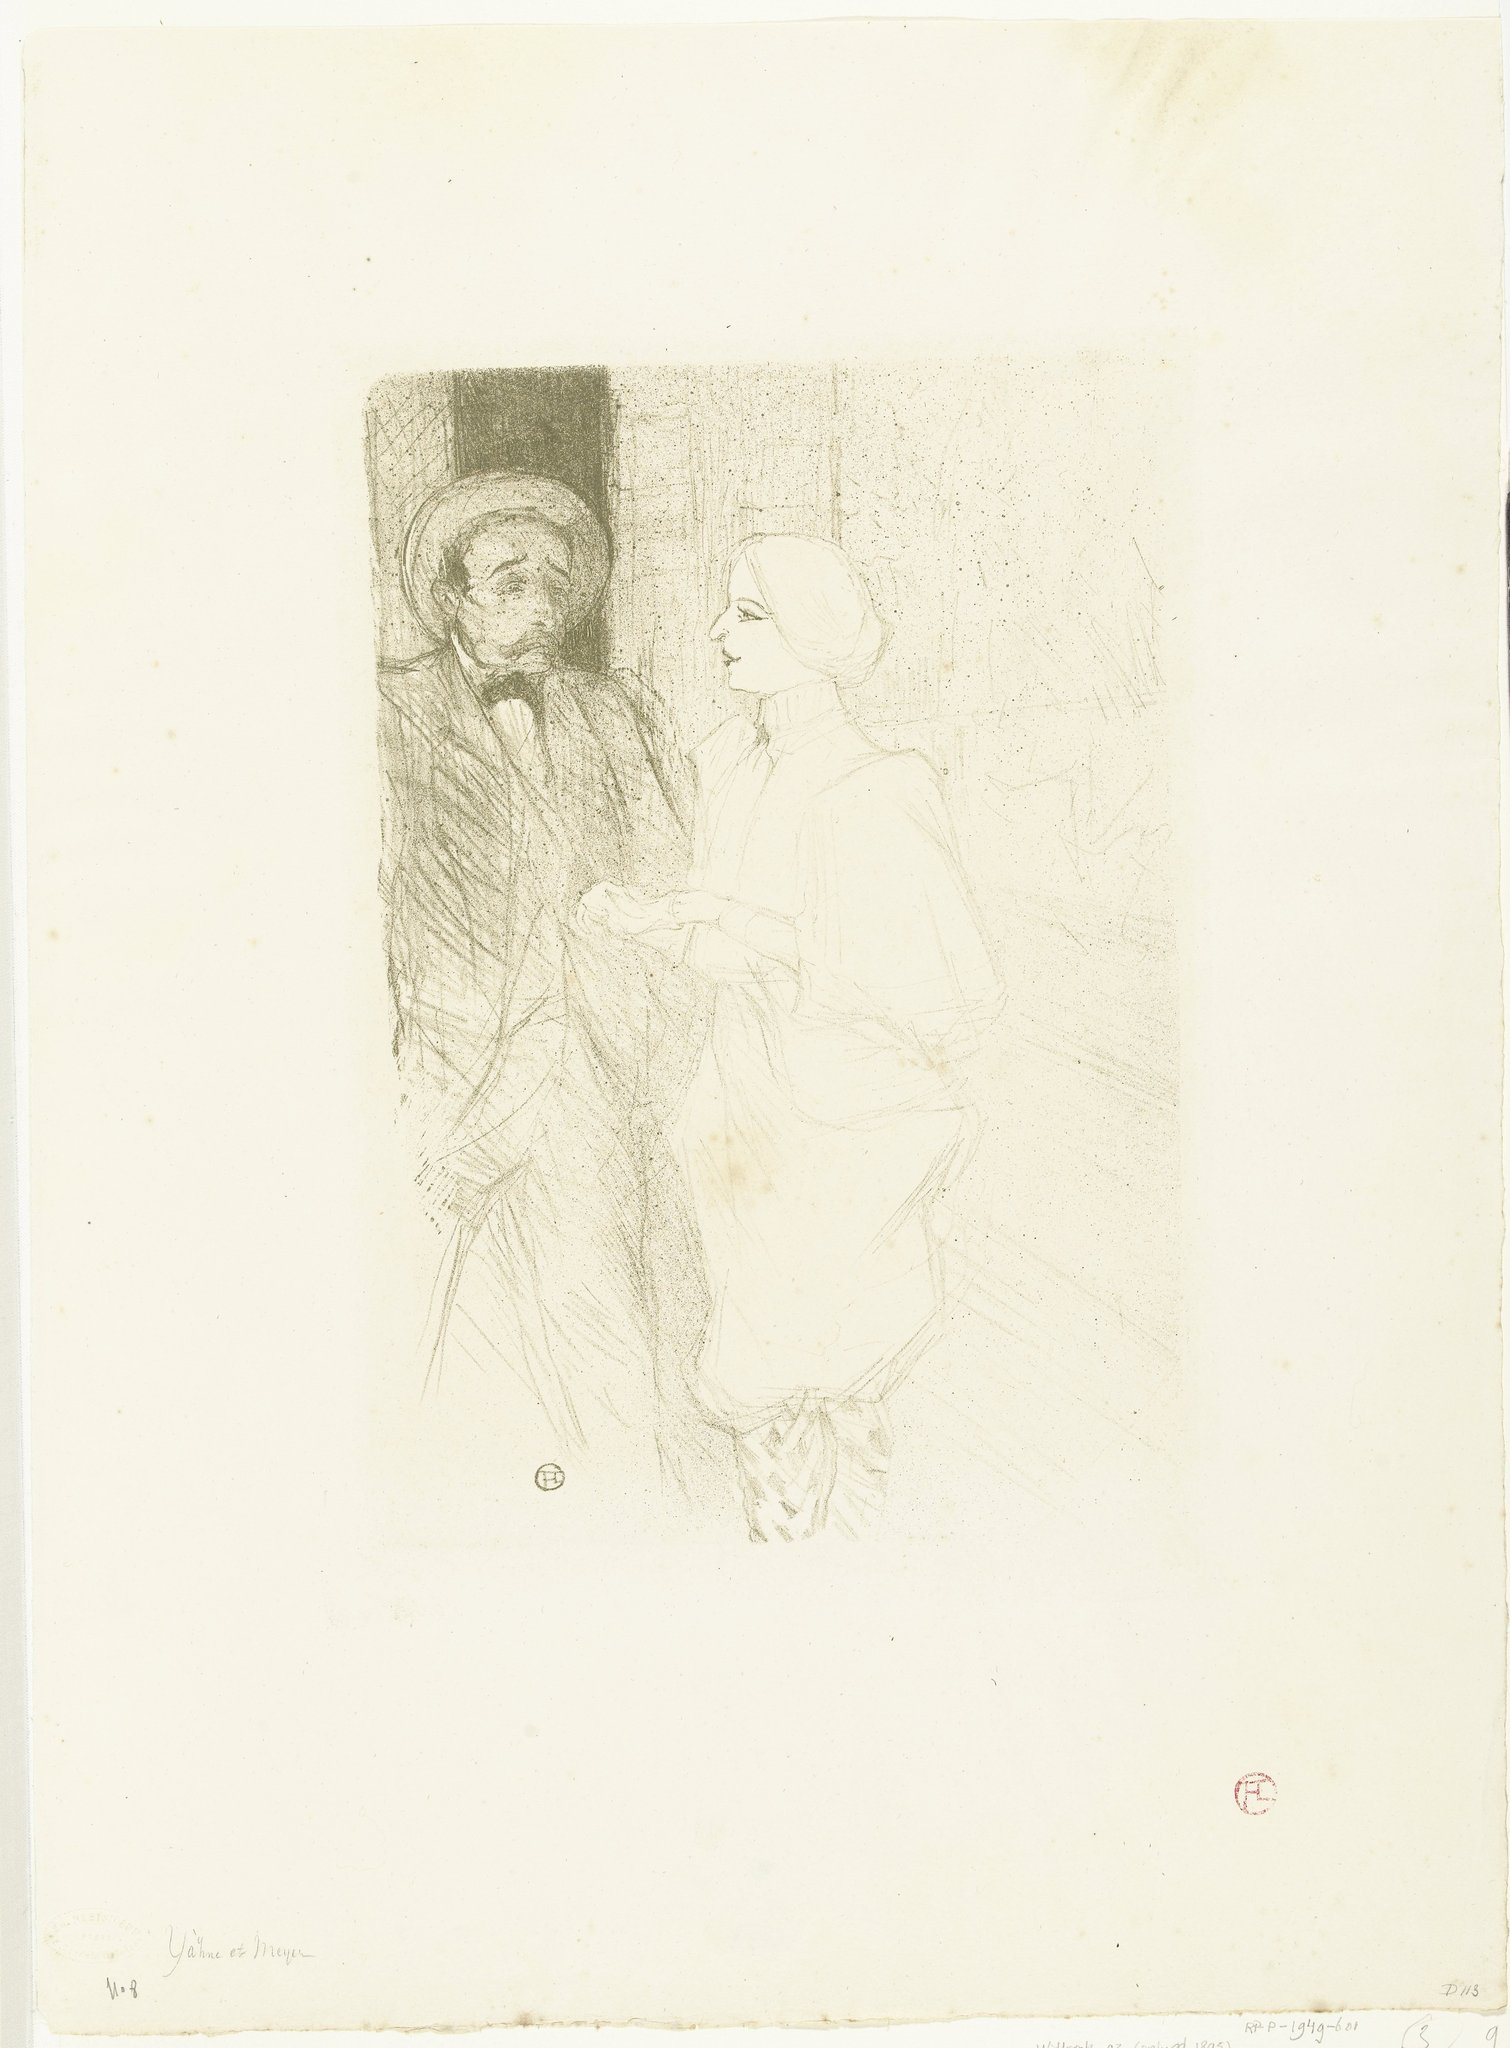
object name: print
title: Yahne et Mayer dans l'Age difficile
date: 1895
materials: paper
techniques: printing, lithograph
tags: actress (on the stage), actor (on the stage)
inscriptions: stamp: Lugt 1338, collector's mark: Lugt 2228, check stamp: Lugt 1573, collector's mark: Lugt 2760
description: Portret van actrice Léonie Yahne en acteur Henri Mayer in toneelstuk l'Age difficile. Léonie Yahne is gekleed in fietskleding.